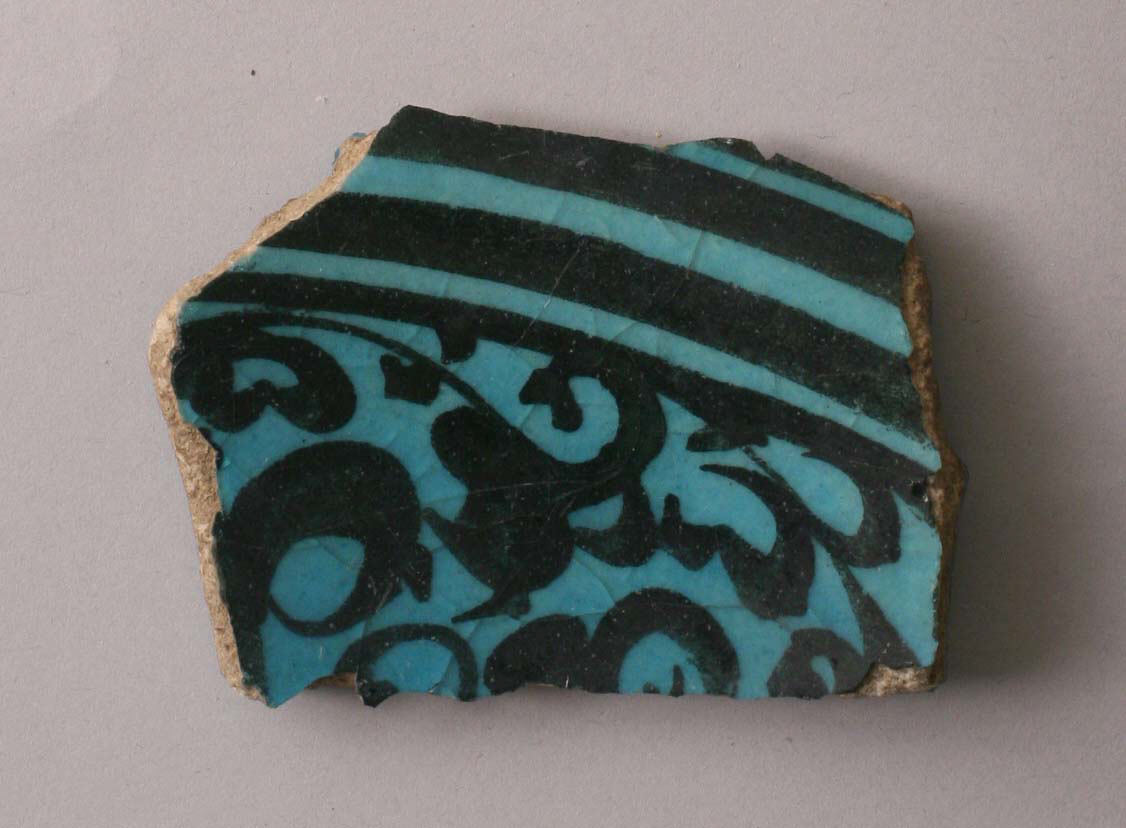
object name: fragment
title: Ceramic Fragment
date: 1201-1300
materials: glaze, stonepaste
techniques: painting, underglaze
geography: syria